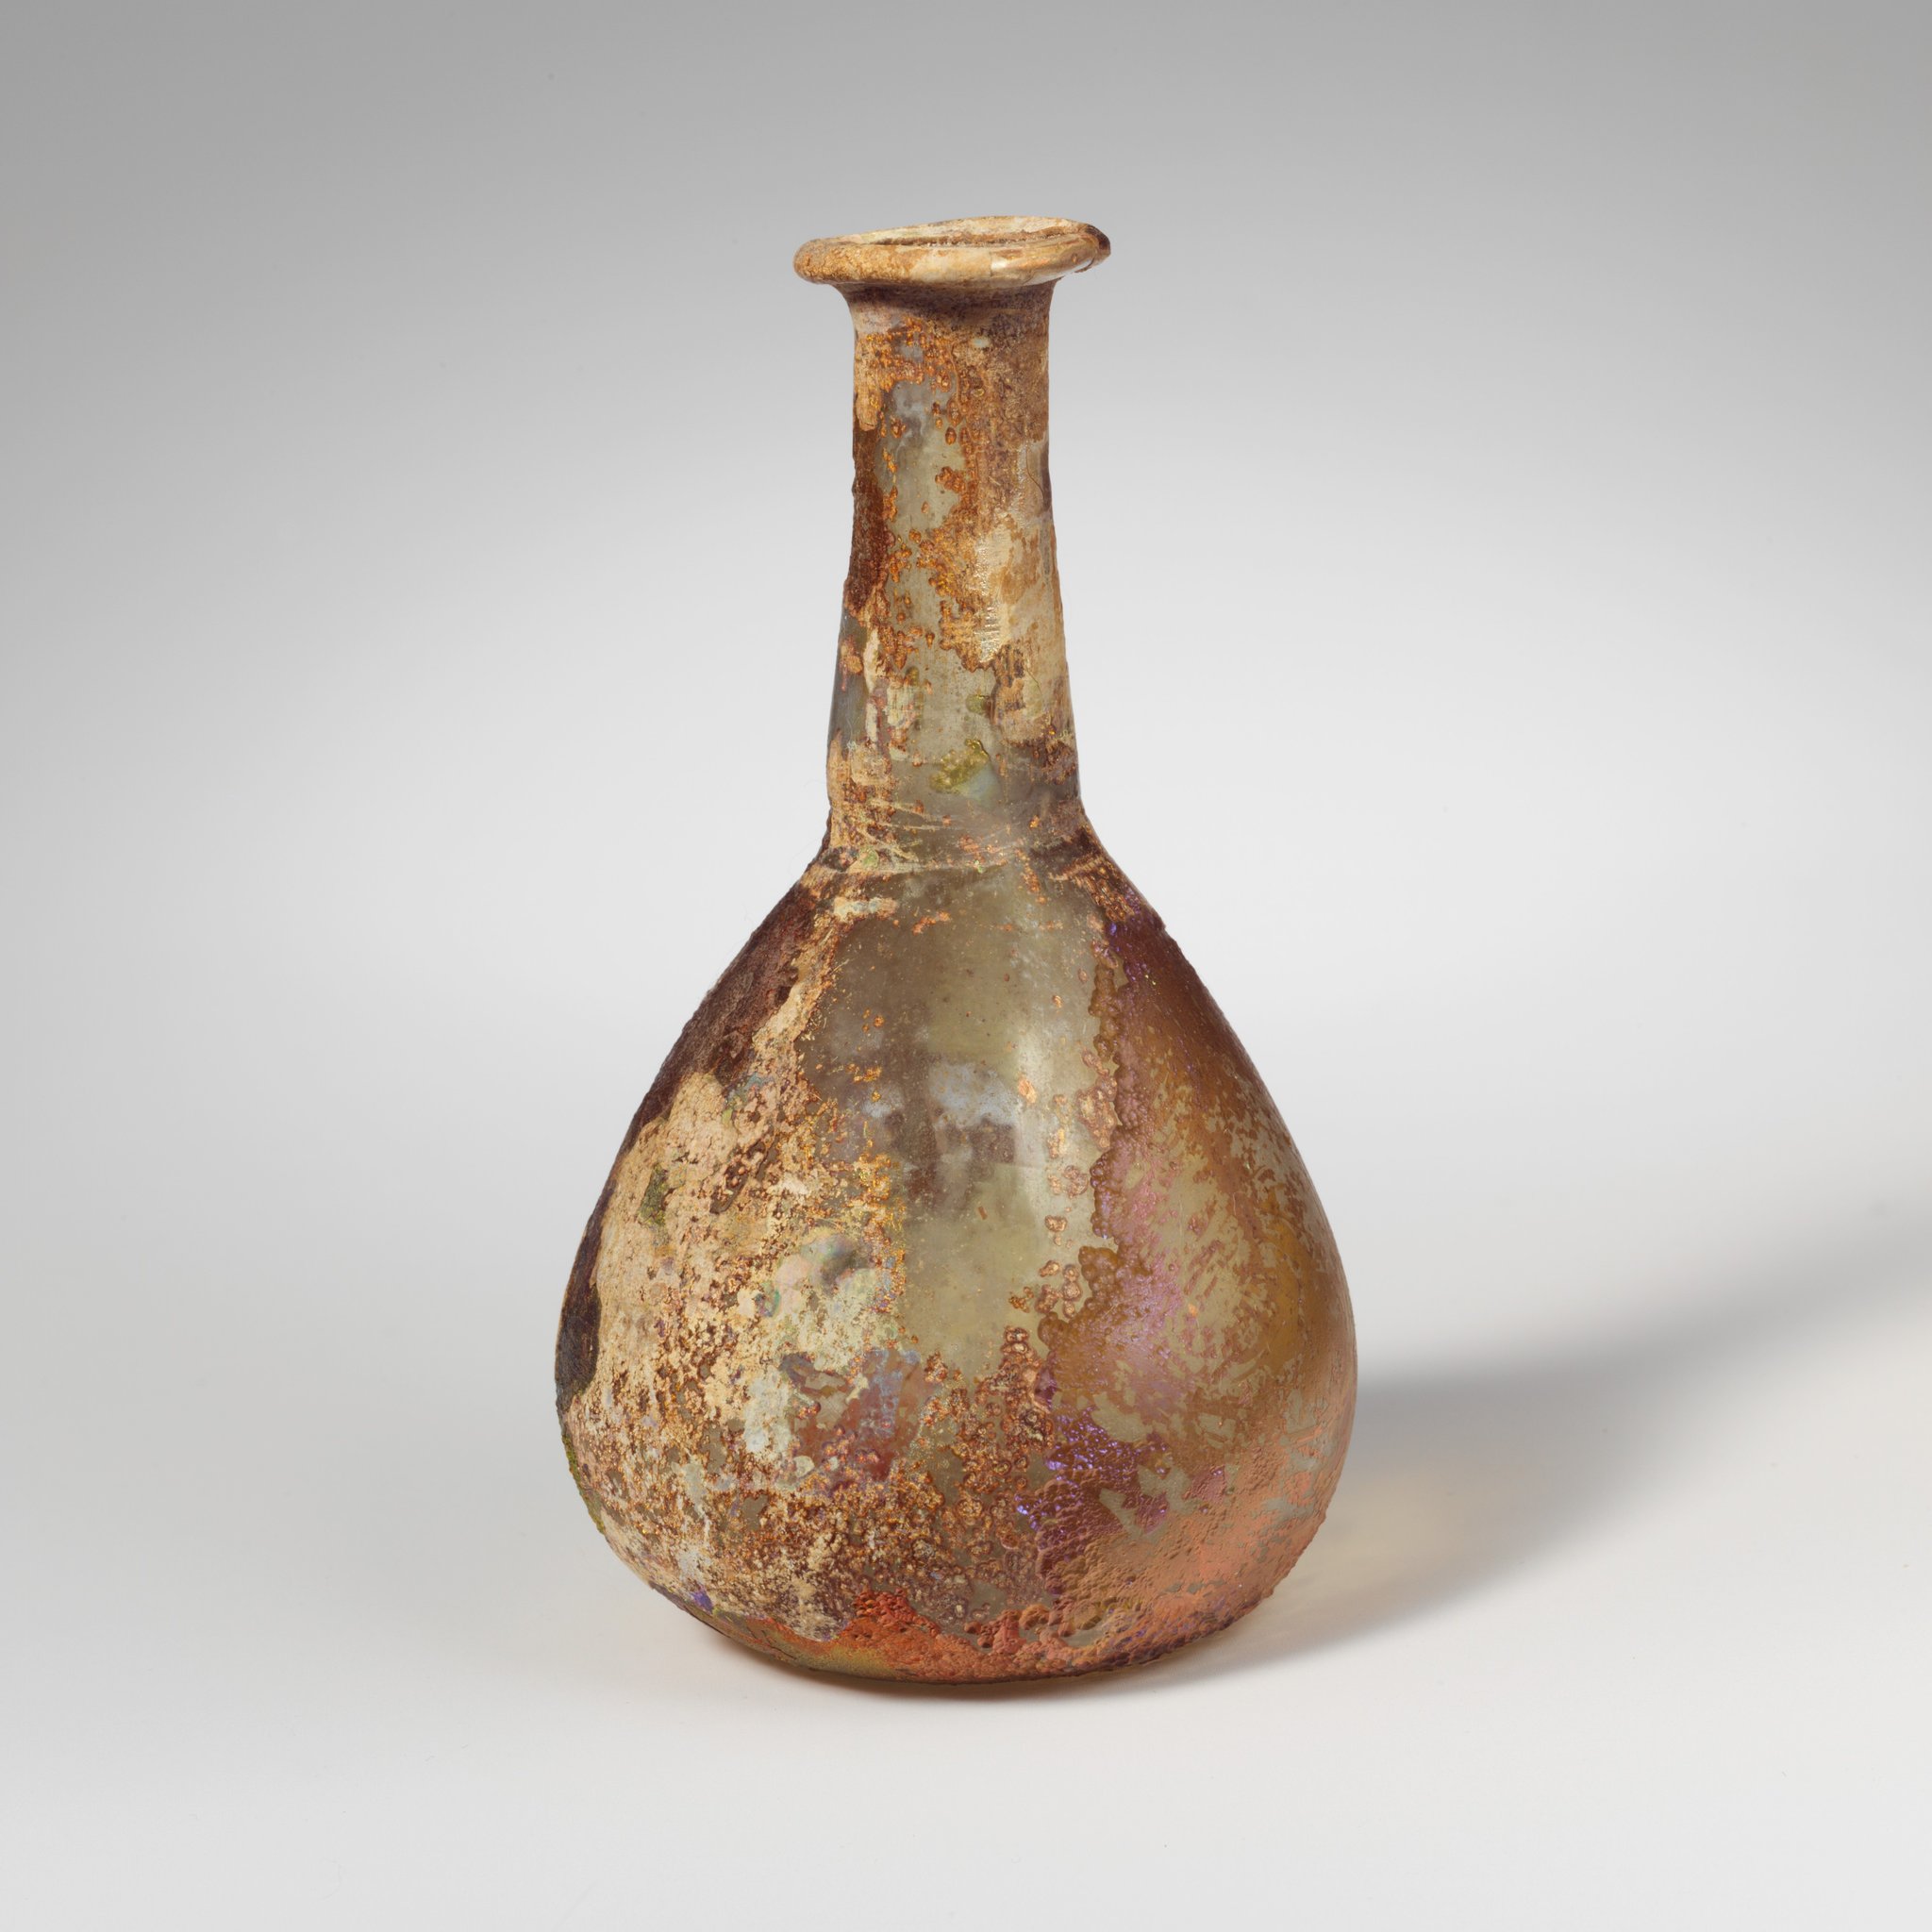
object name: perfume bottle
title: Glass perfume bottle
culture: roman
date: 1-200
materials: glass